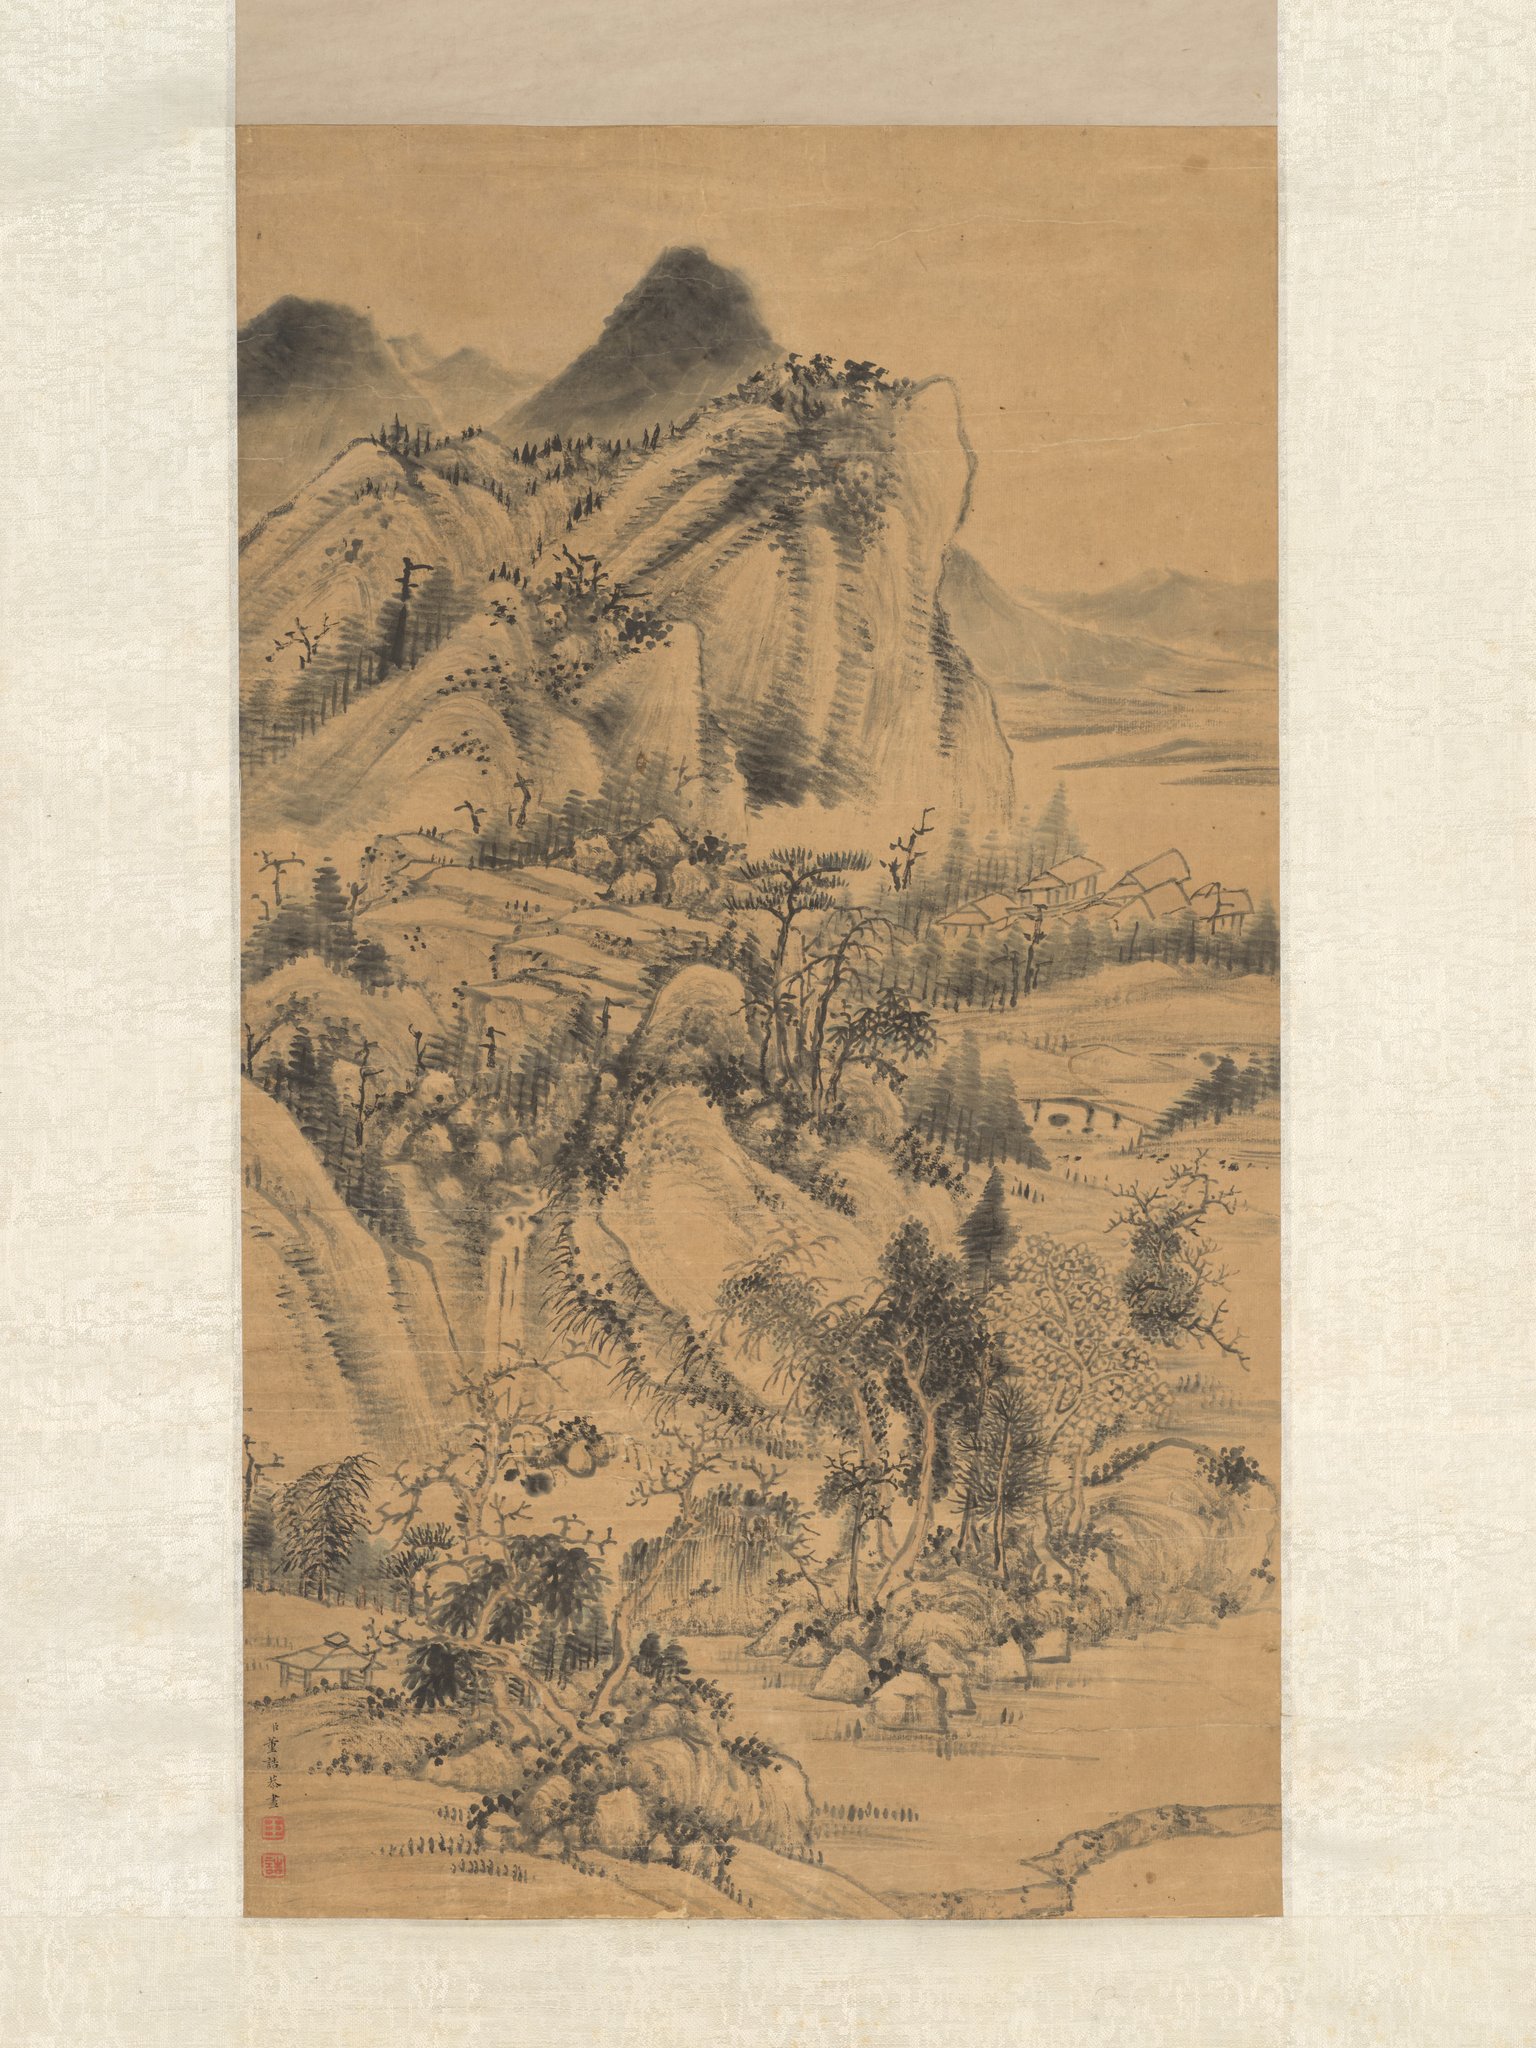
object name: hanging scroll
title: Landscape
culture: chinese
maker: dong gao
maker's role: artist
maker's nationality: chinese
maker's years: 1740-1818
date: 1701-1900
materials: ink, paper